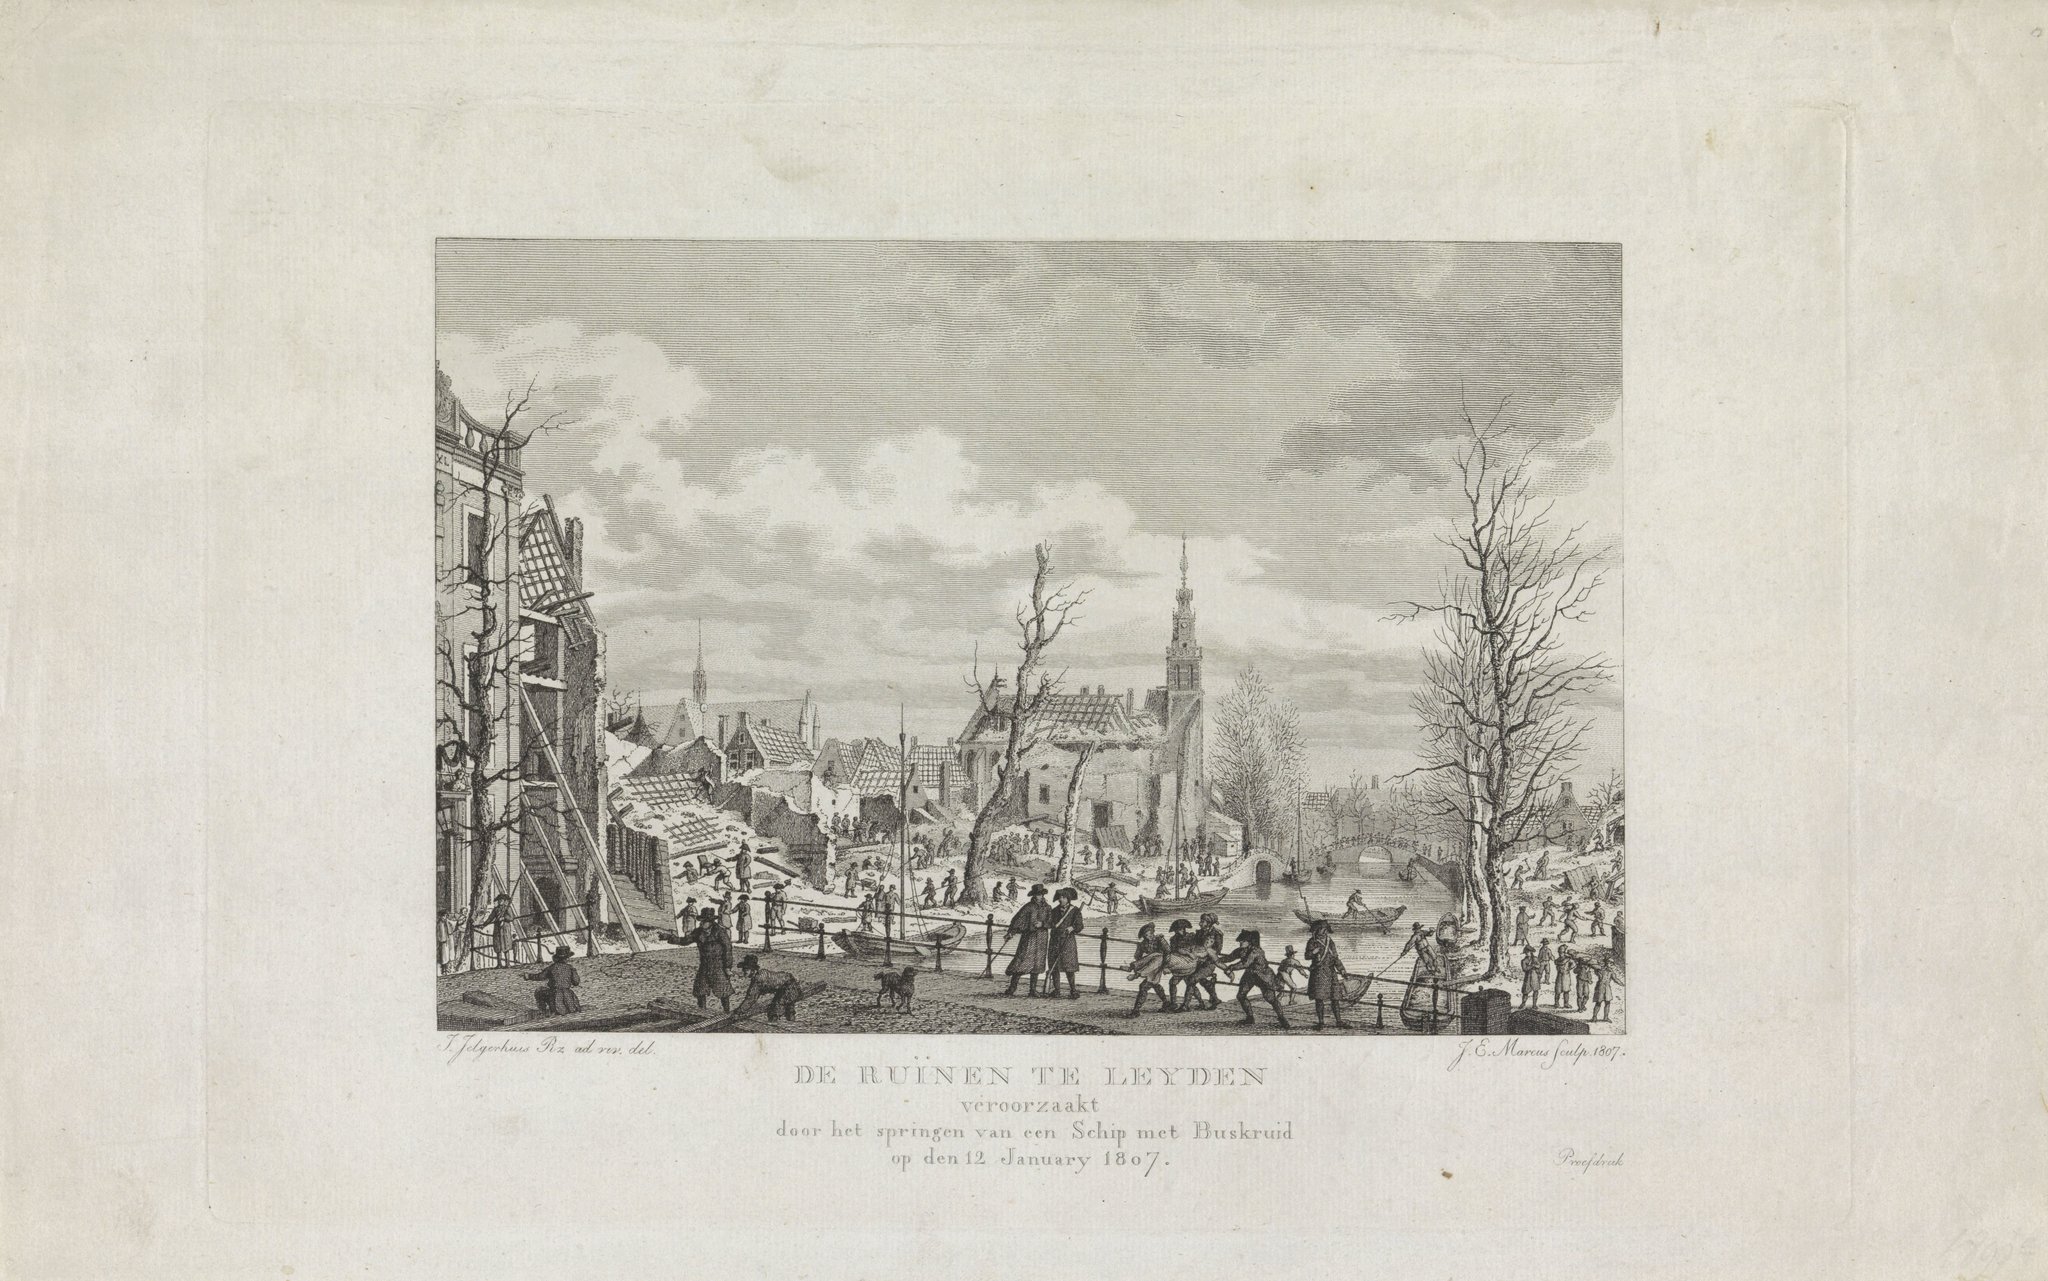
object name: print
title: Ruïnes op het Rapenburg te Leiden na de ramp, 1807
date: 1807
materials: paper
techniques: etching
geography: netherlands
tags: death caused by undesired effects of human activities, in traffic, at work, etc., gunpowder disaster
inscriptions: collector's mark: Lugt 2228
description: Gezicht vanaf de Nieuwsteegbrug op het verwoest gebied na de buskruitramp op het Steenschuur, een gracht in het verlengde van het Rapenburg, te Leiden op 12 januari 1807. Opruimwerkzaamheden na de ramp, centraal de Saaihal, links in de verte de Pieterskerk. Op de voorgrond wordt het lichaam van een slachtoffer weggedragen.